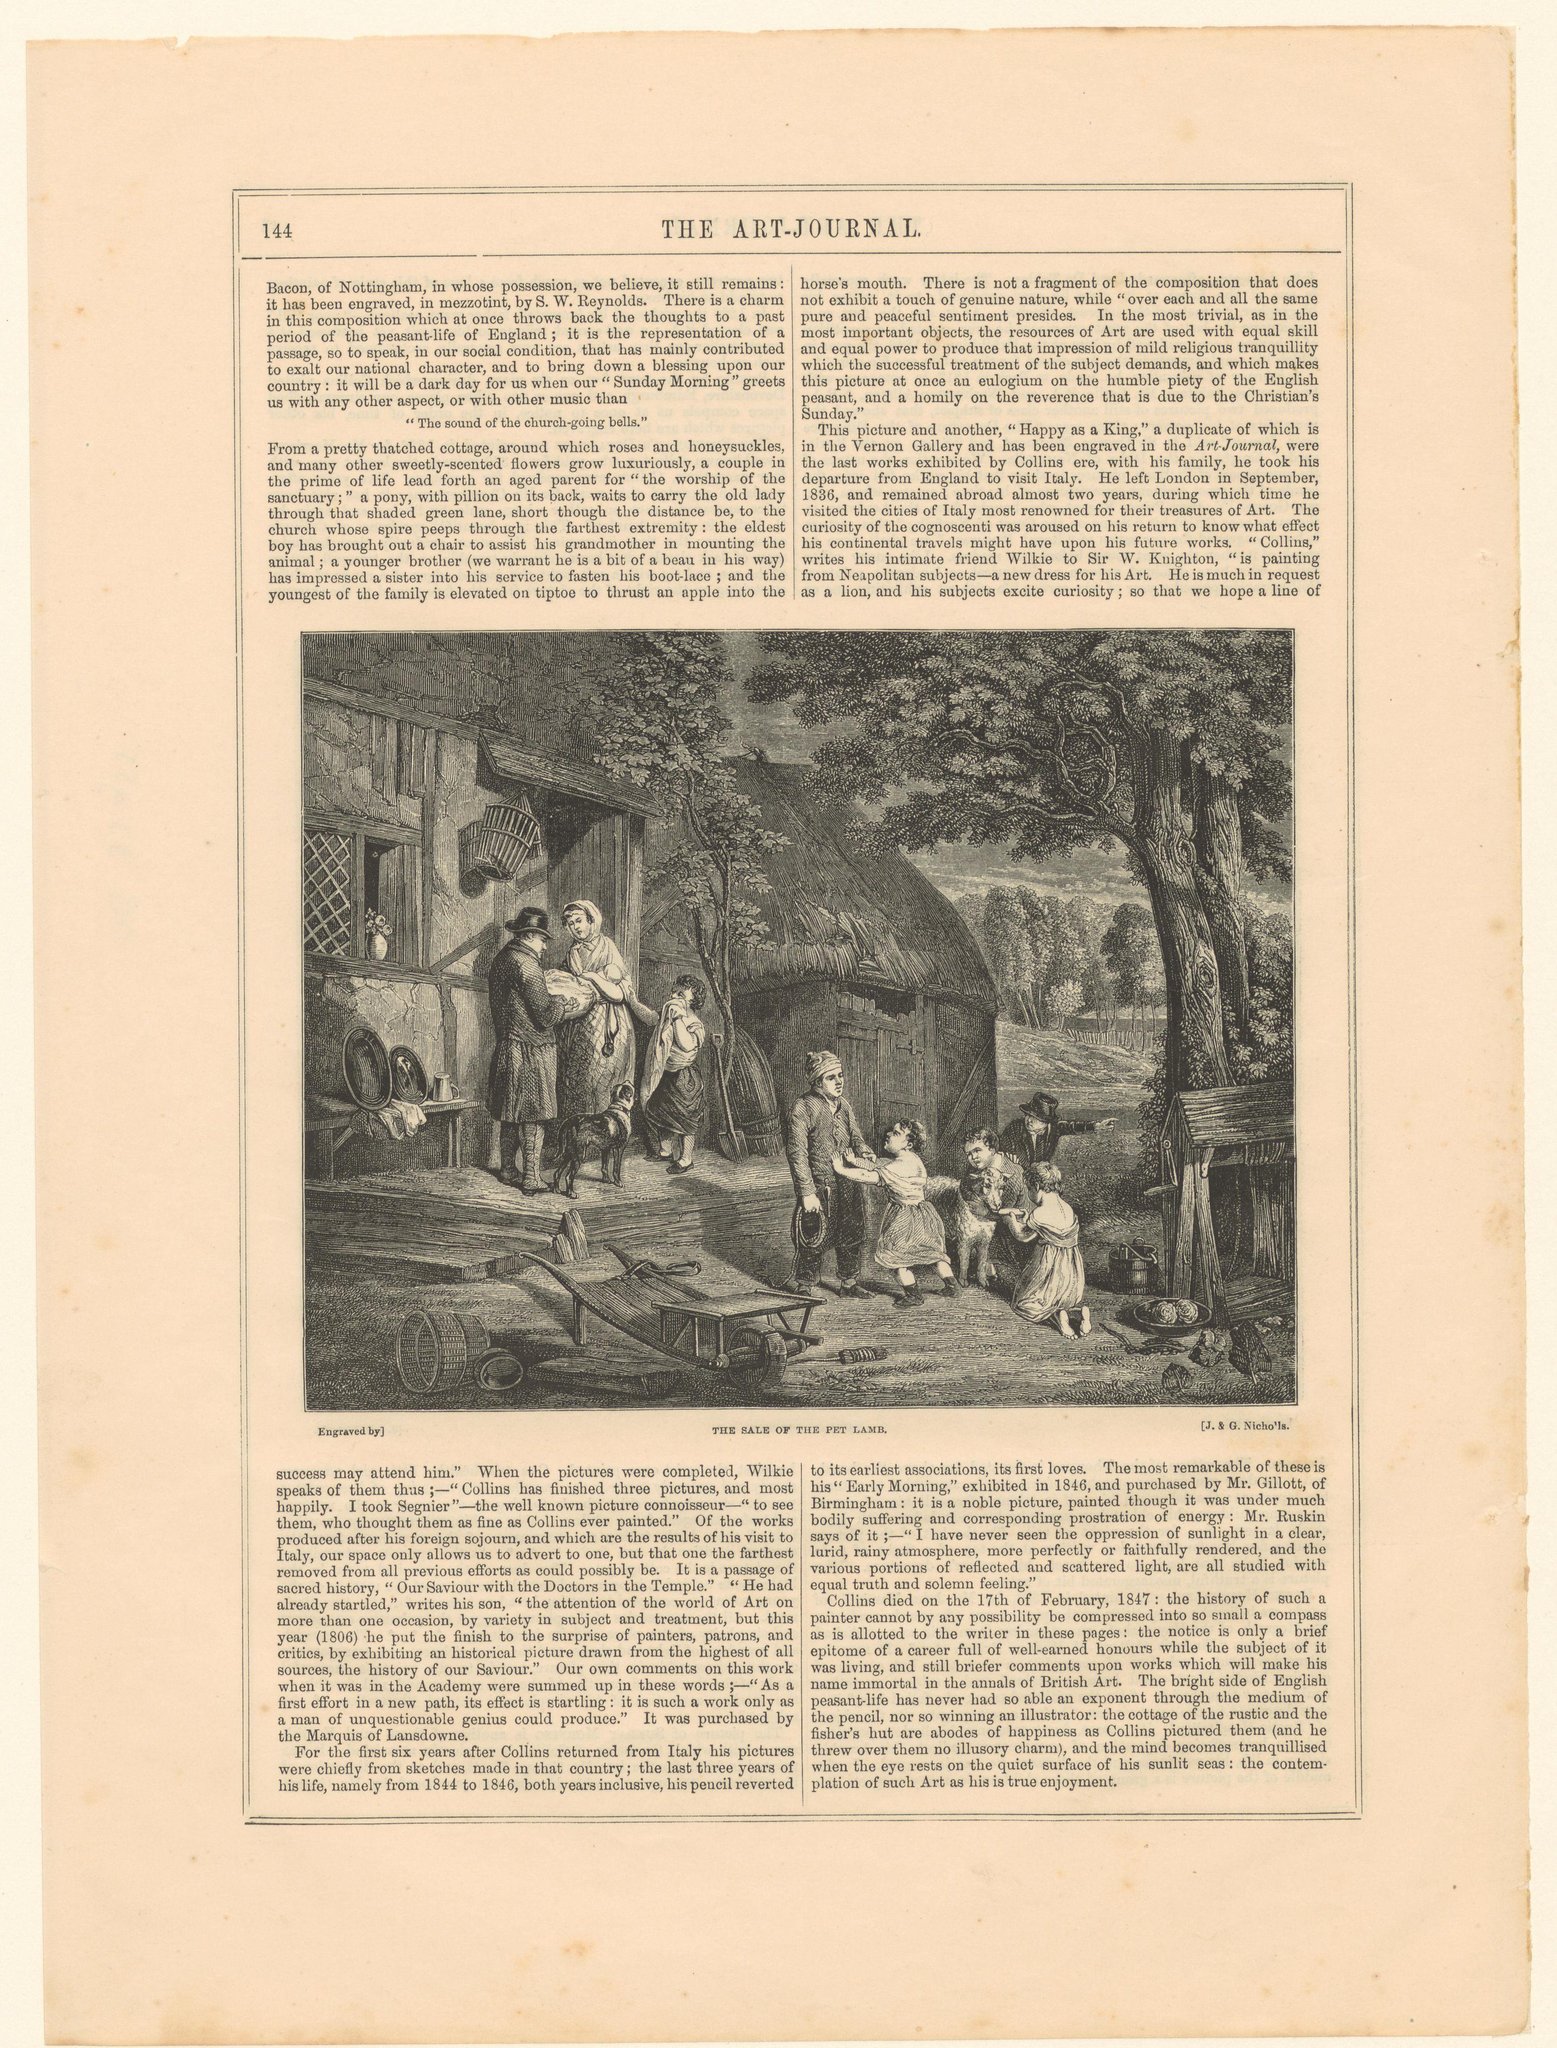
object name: print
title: Familie met paard bij een huis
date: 1855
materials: paper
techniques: letterpress printing, engraving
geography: london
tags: family life at home, horse, civic architecture; edifices; dwellings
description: Prent uit: The Art Journal (1855), 1855, p. 143.